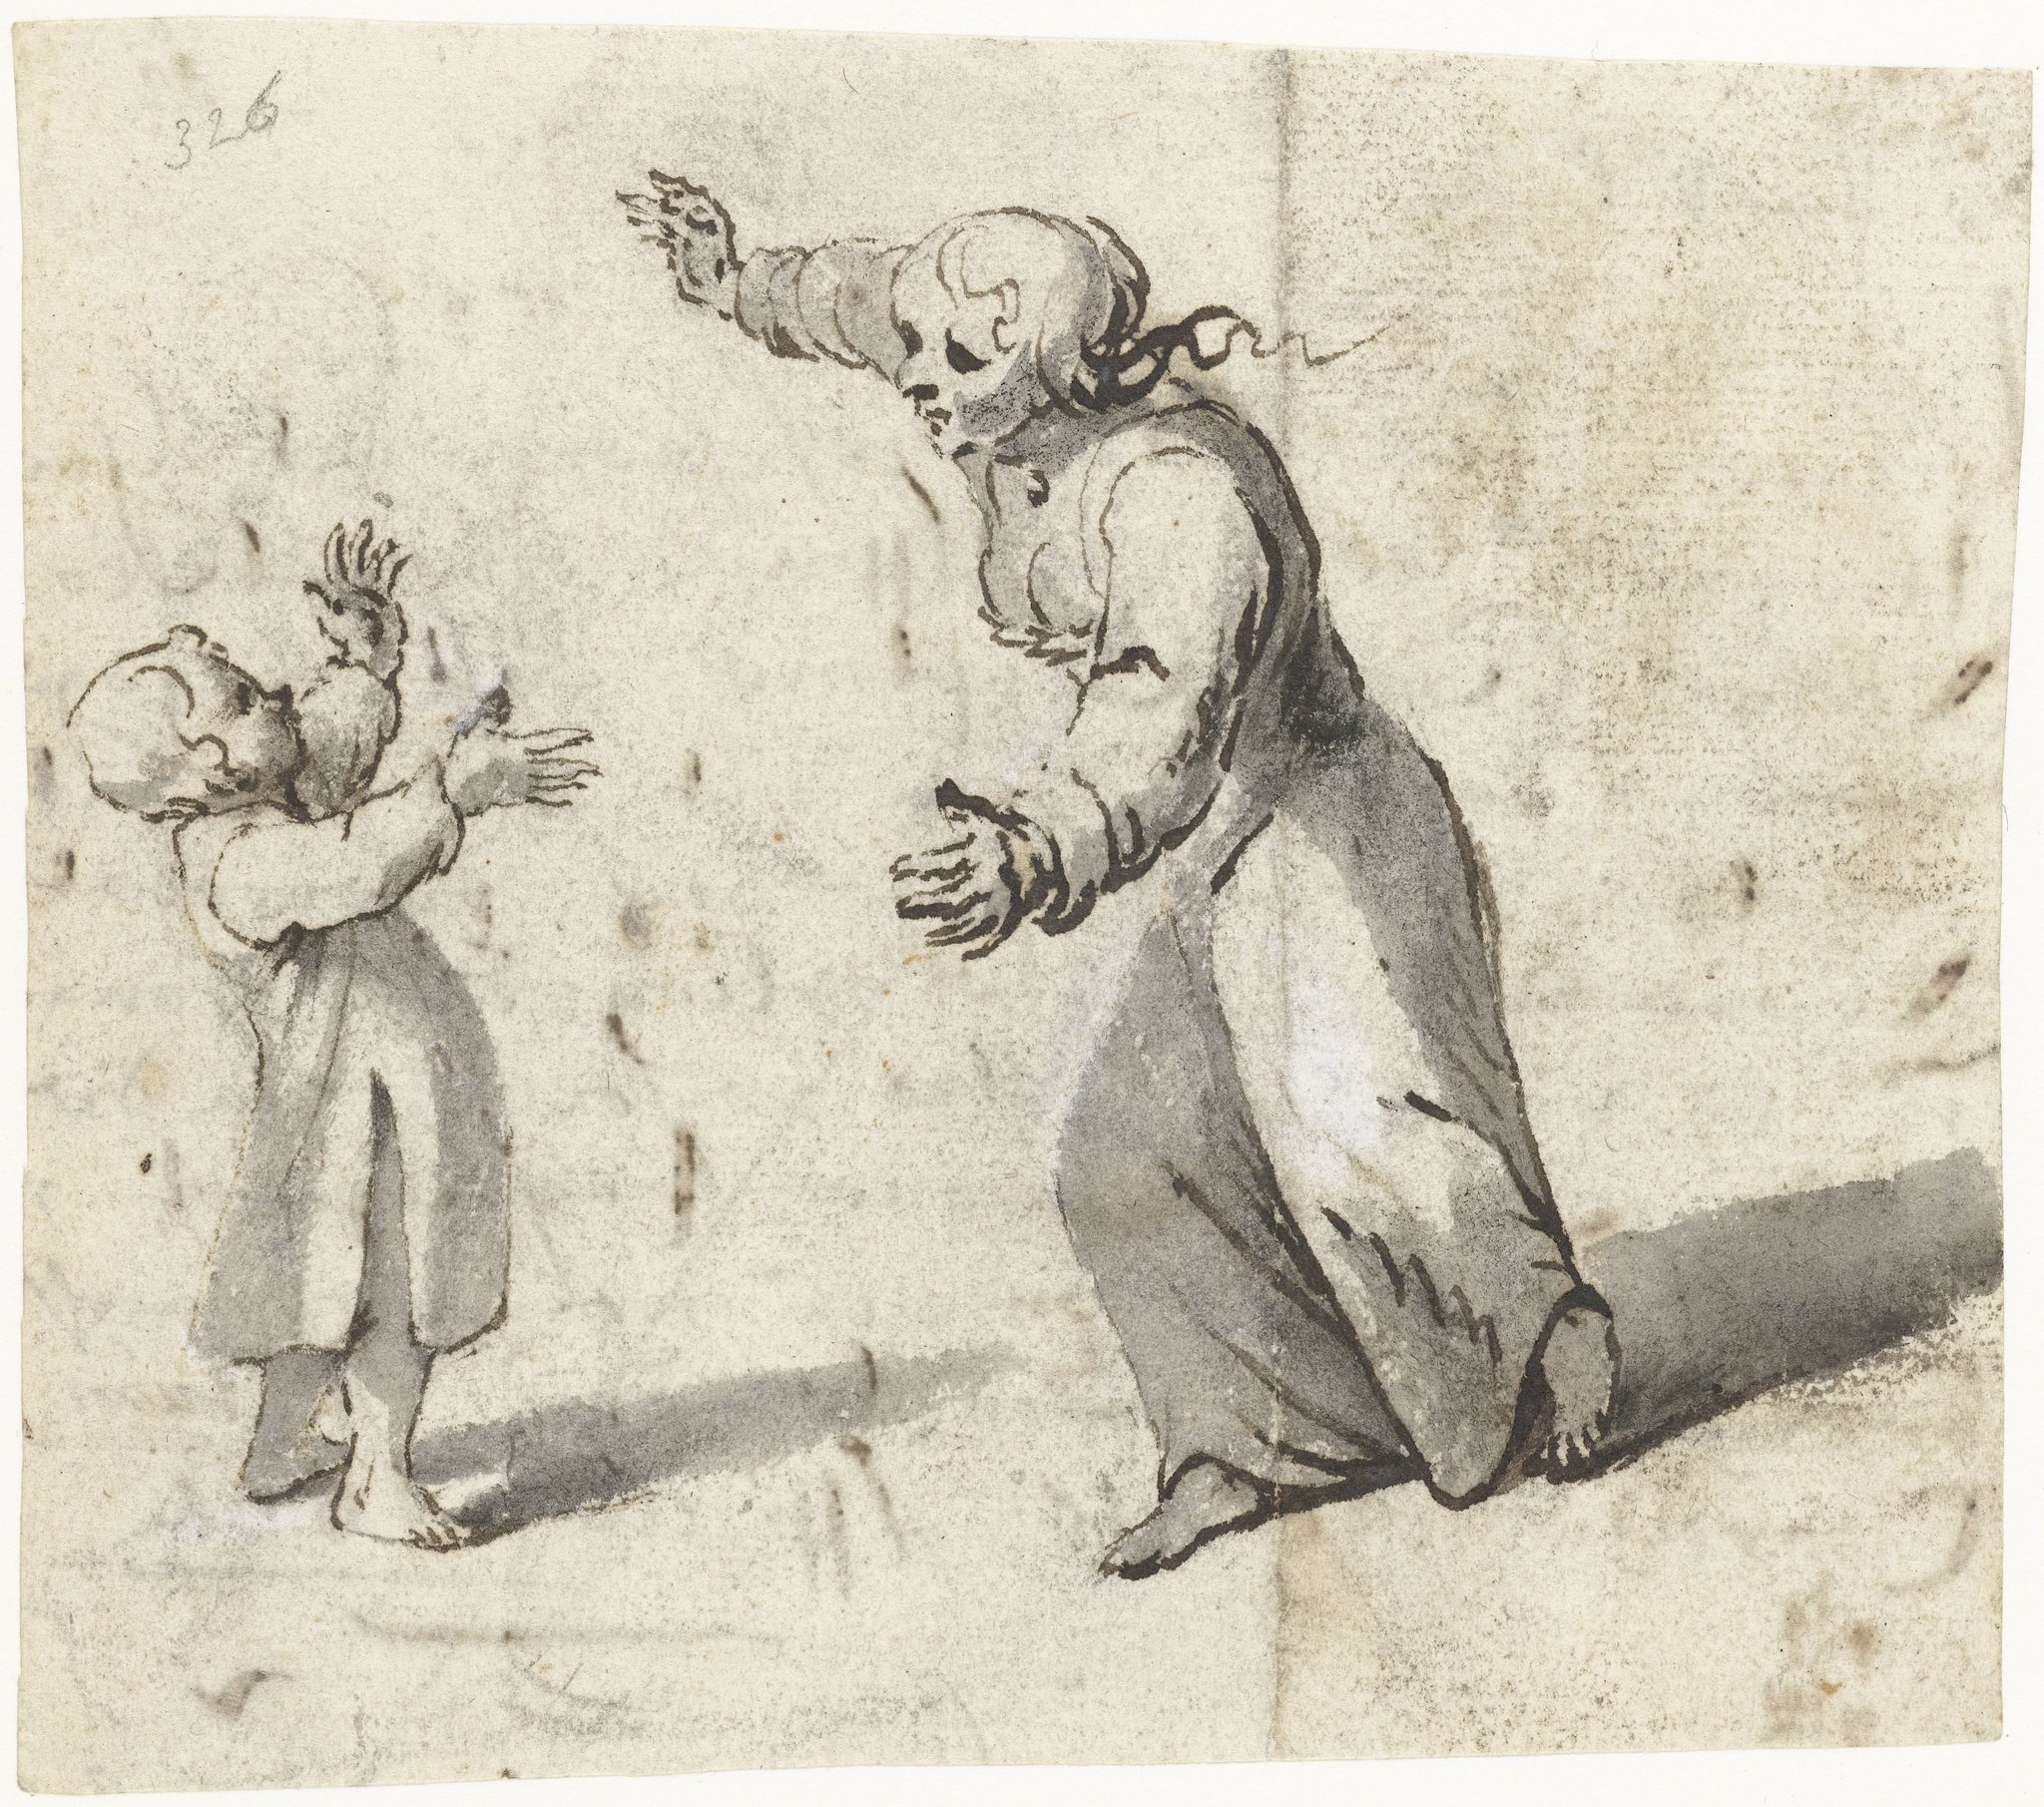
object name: drawing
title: Moeder en kind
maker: moses ter borch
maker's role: draughtsman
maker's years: 1645-1667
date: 1662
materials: chalk, paint, gouache, ink, paper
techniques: brush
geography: zwolle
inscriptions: annotation